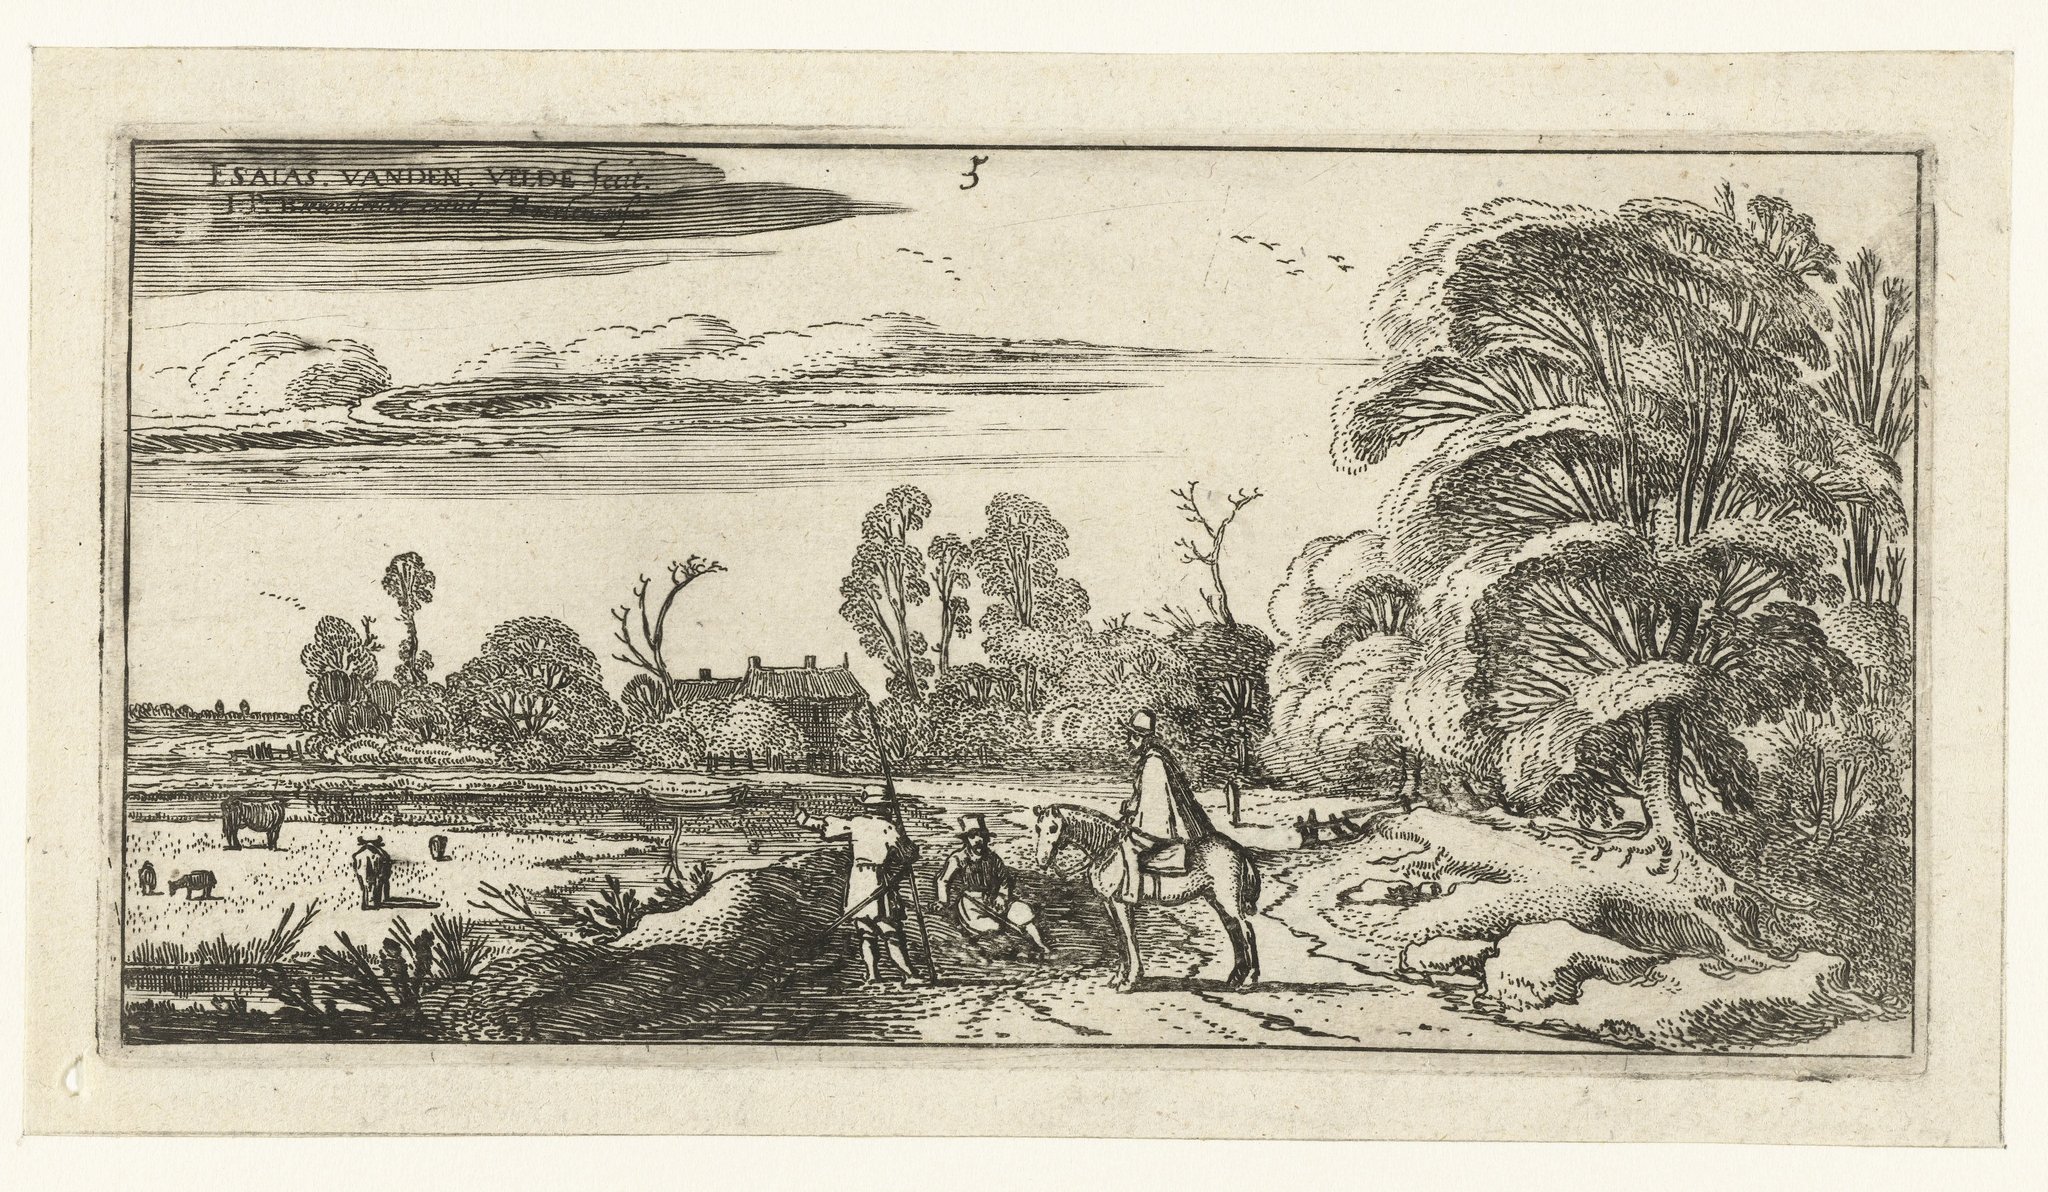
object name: print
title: Landschappen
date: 1615-1616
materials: paper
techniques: engraving, etching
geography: haarlem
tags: prospect of village, silhouette of village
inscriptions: collector's mark: Lugt 964